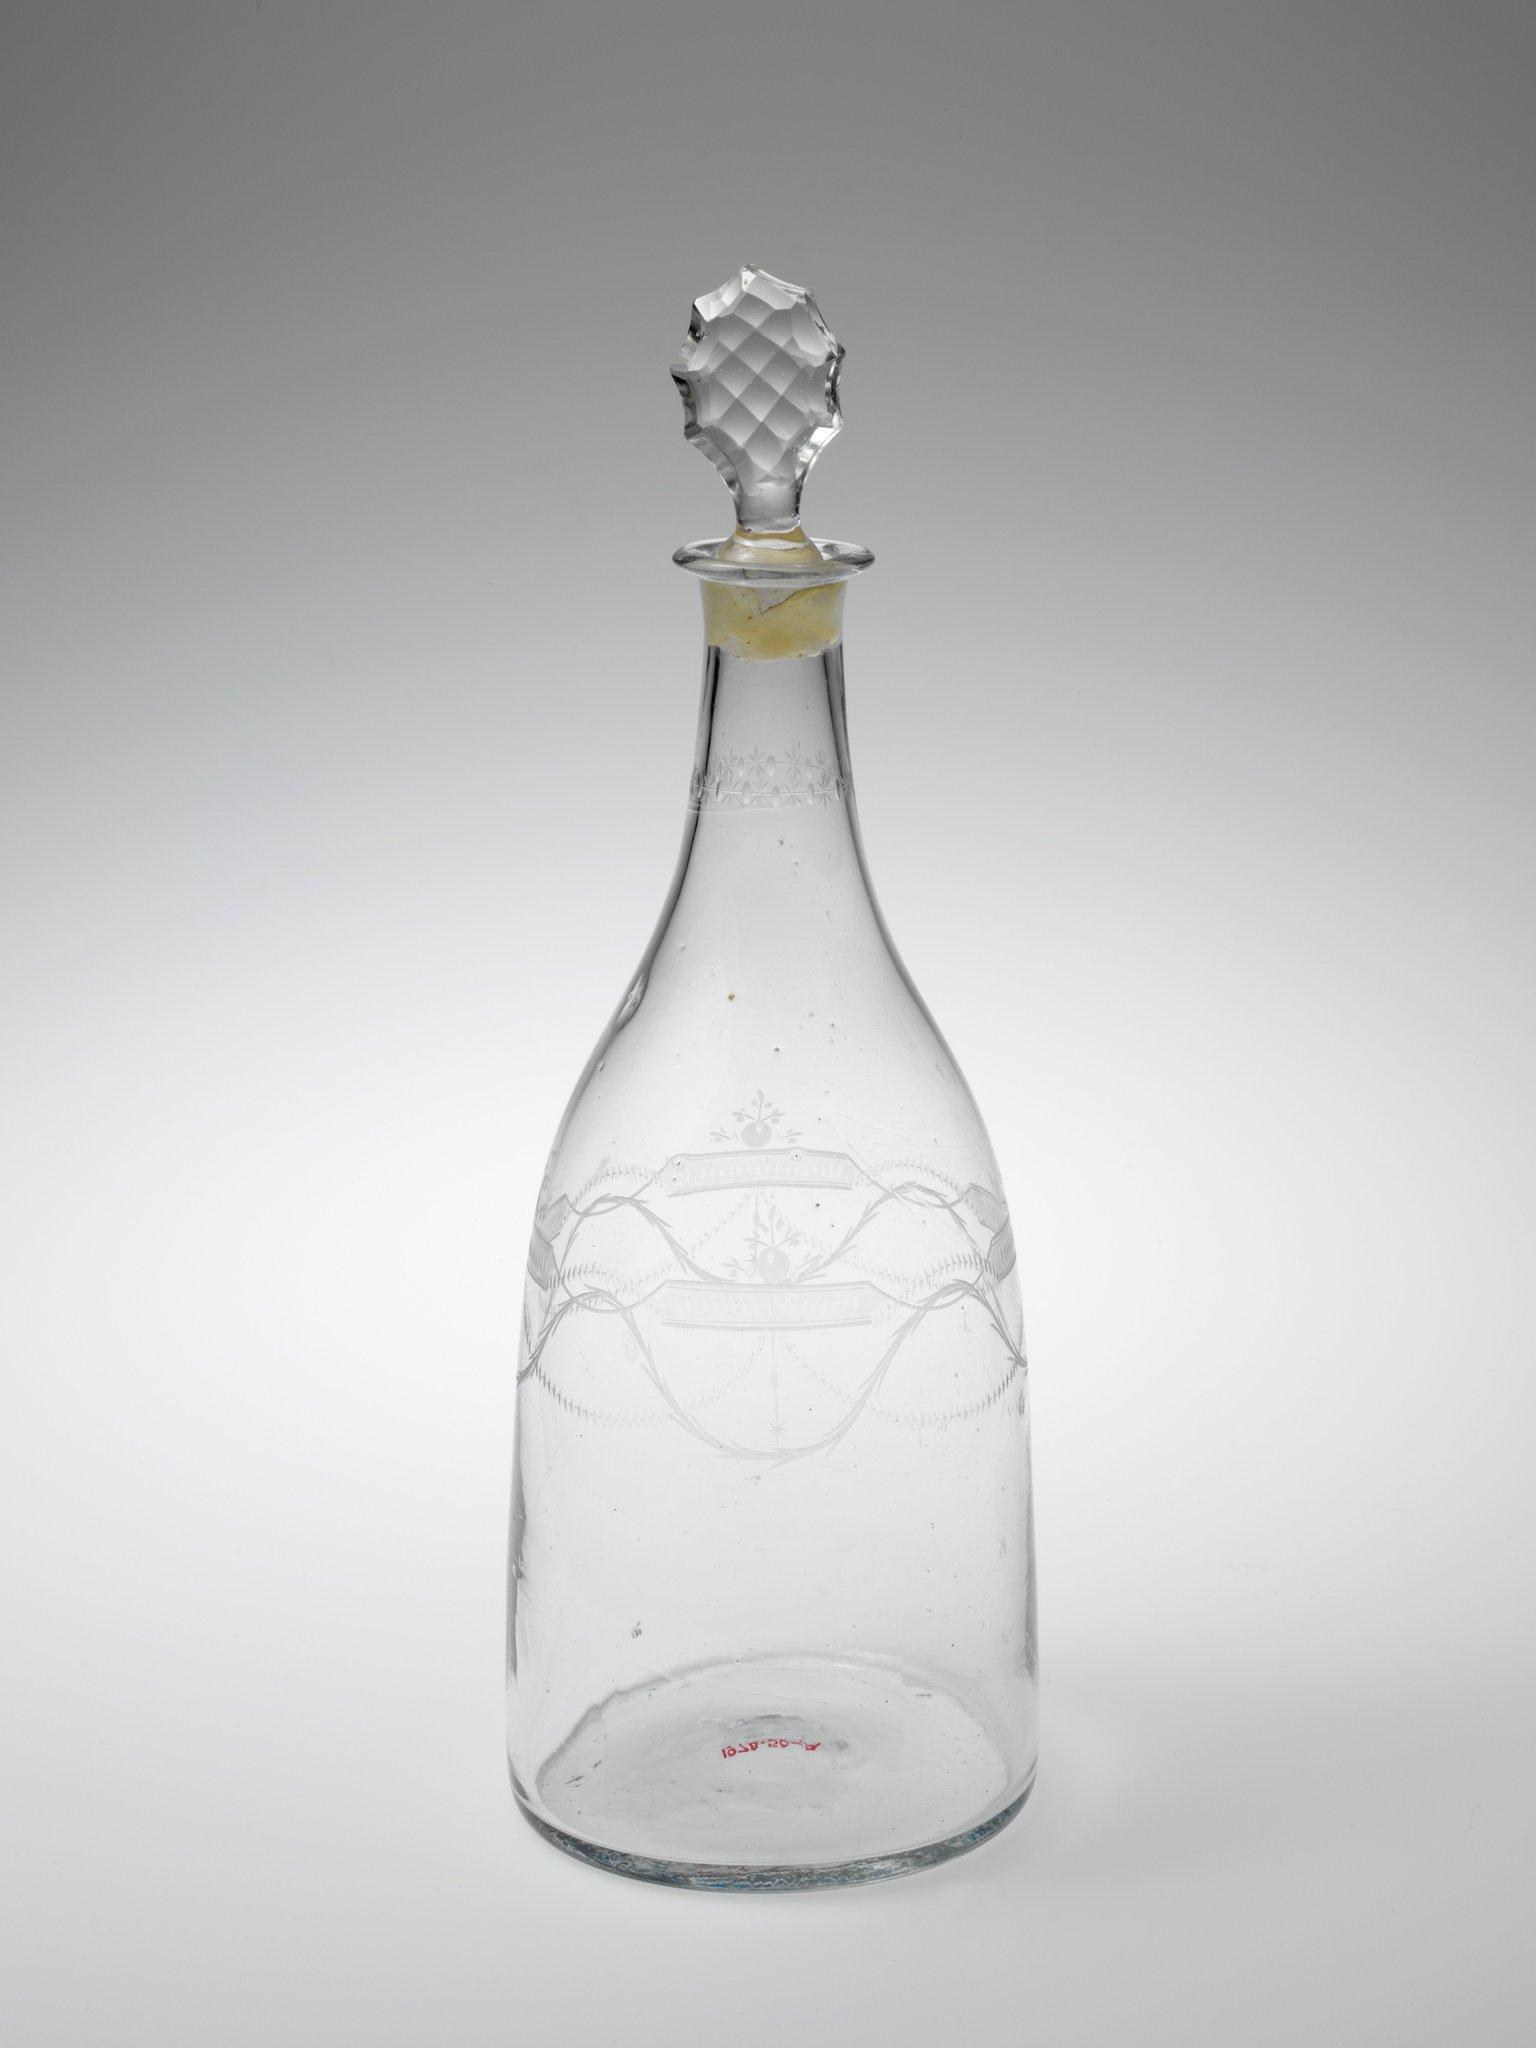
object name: decanter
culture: bohemian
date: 1790-1810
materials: glass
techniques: glassblowing, cutting, engraving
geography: czech republic